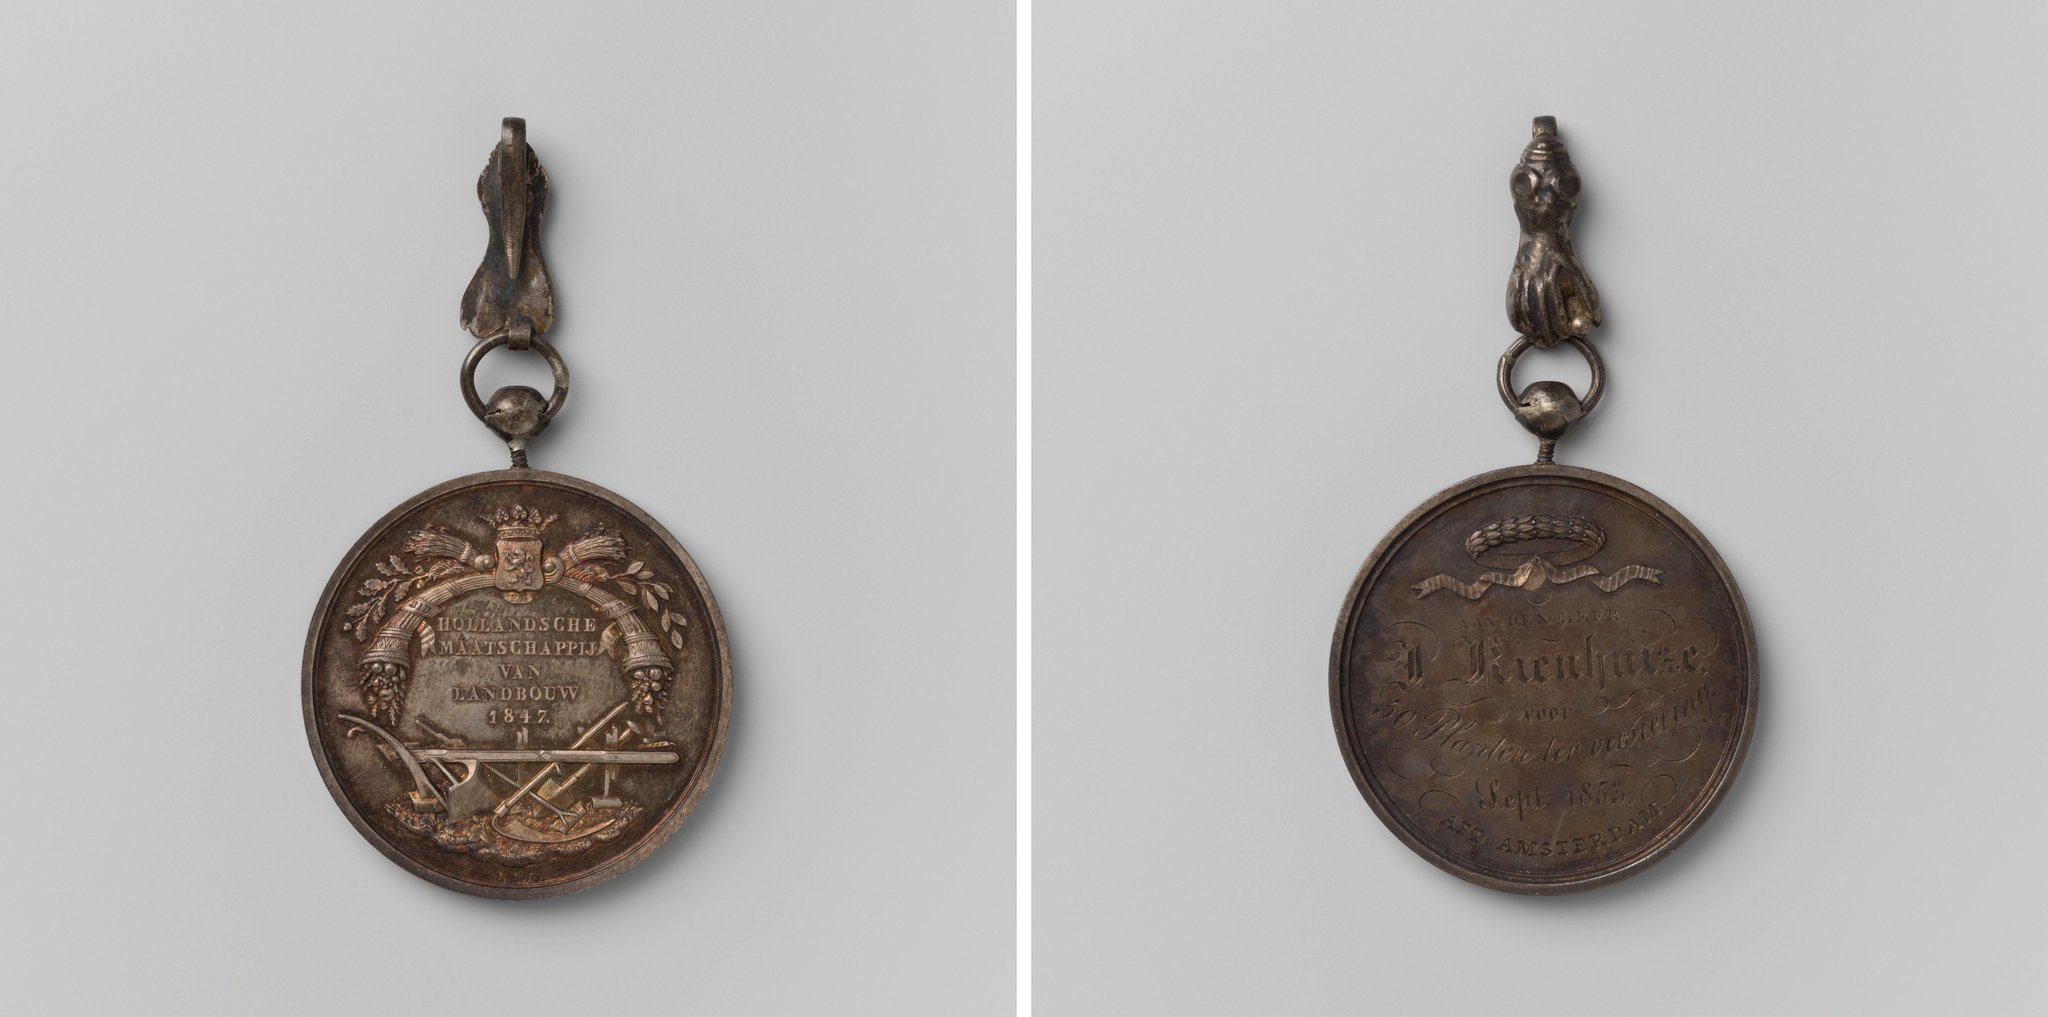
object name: medal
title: Afdeling Amsterdam van de Hollandsche Maatschappij van Landbouw, penning uitgereikt aan D. Kienhuize voor vijftig sierplanten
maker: johannis petrus schouberg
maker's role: die cutter, draughtsman, print maker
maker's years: 1798-1864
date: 1853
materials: silver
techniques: engraving, striking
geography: utrecht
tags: amsterdam, holland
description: Zilveren penning aan draagring en sierspeld in vorm van hand. Voorzijde: gekroond wapenschild liggend op twee korenschoven, twee omgekeerde, gevulde hoorns van overvloed, een eike- en een wilgetak boven opschrift en landbouwwerktuigen. Keerzijde: krans van olijftakken met lint boven opschriften.